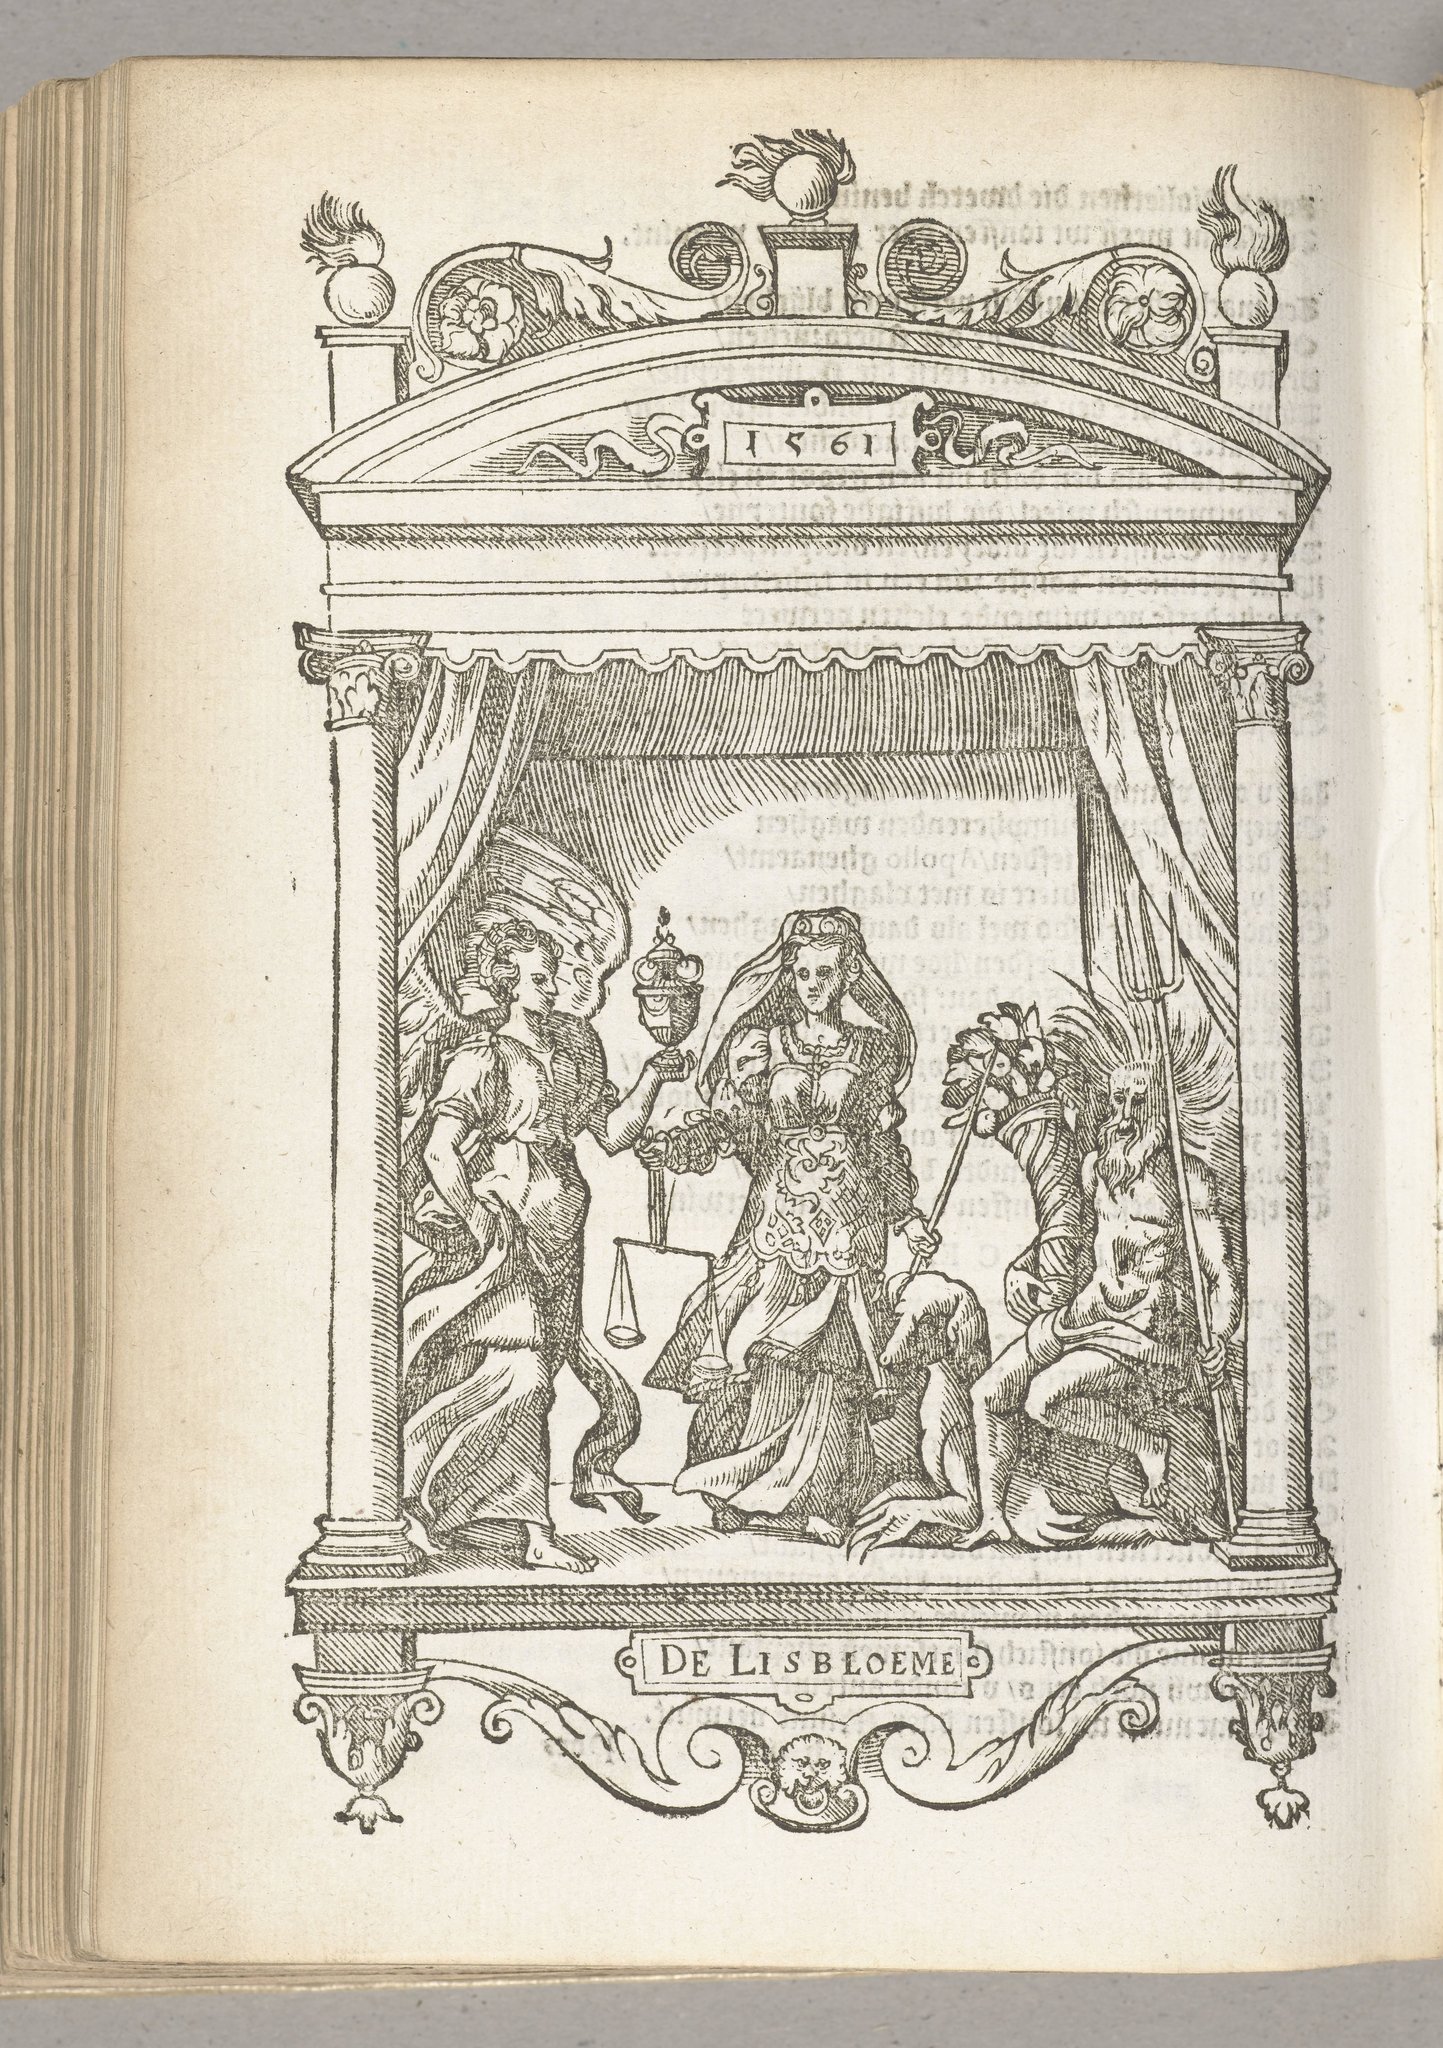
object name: print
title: De Lisbloeme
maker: Anonymous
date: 1561-1562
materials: paper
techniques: woodcut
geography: antwerp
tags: theatre, theatrical performance, chamber of rhetoric (dutch: 'rederijkerskamer'), antwerp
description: Illustratie in: Spelen van sinne vol scoone moralisacien wtleggingen ende bediedenissen op alle loeflijcke consten waer inne men claerlijck ghelijck in eene spieghel, figuerlijck, poetelijck en retorijckelijck mach aenschouwen hoe nootsakelijck ende dienstelijck die selve consten allen menschen zijn : ghespeelt met octroy der Con. Ma. binnen der stadt van Andtwerpen op dLant-Juweel by die veerthien cameren van Retorijcken die hen daer ghepresenteert hebben den derden dach Augusti int Jaer ons Heeren 1561, op die questie : wat den mensch aldermeest tot conste verwect. Uitgave van 1562, p. h (3) verso. In het exemplaar in de Rijksmuseum Research Library, signatuur: 325 D 20.